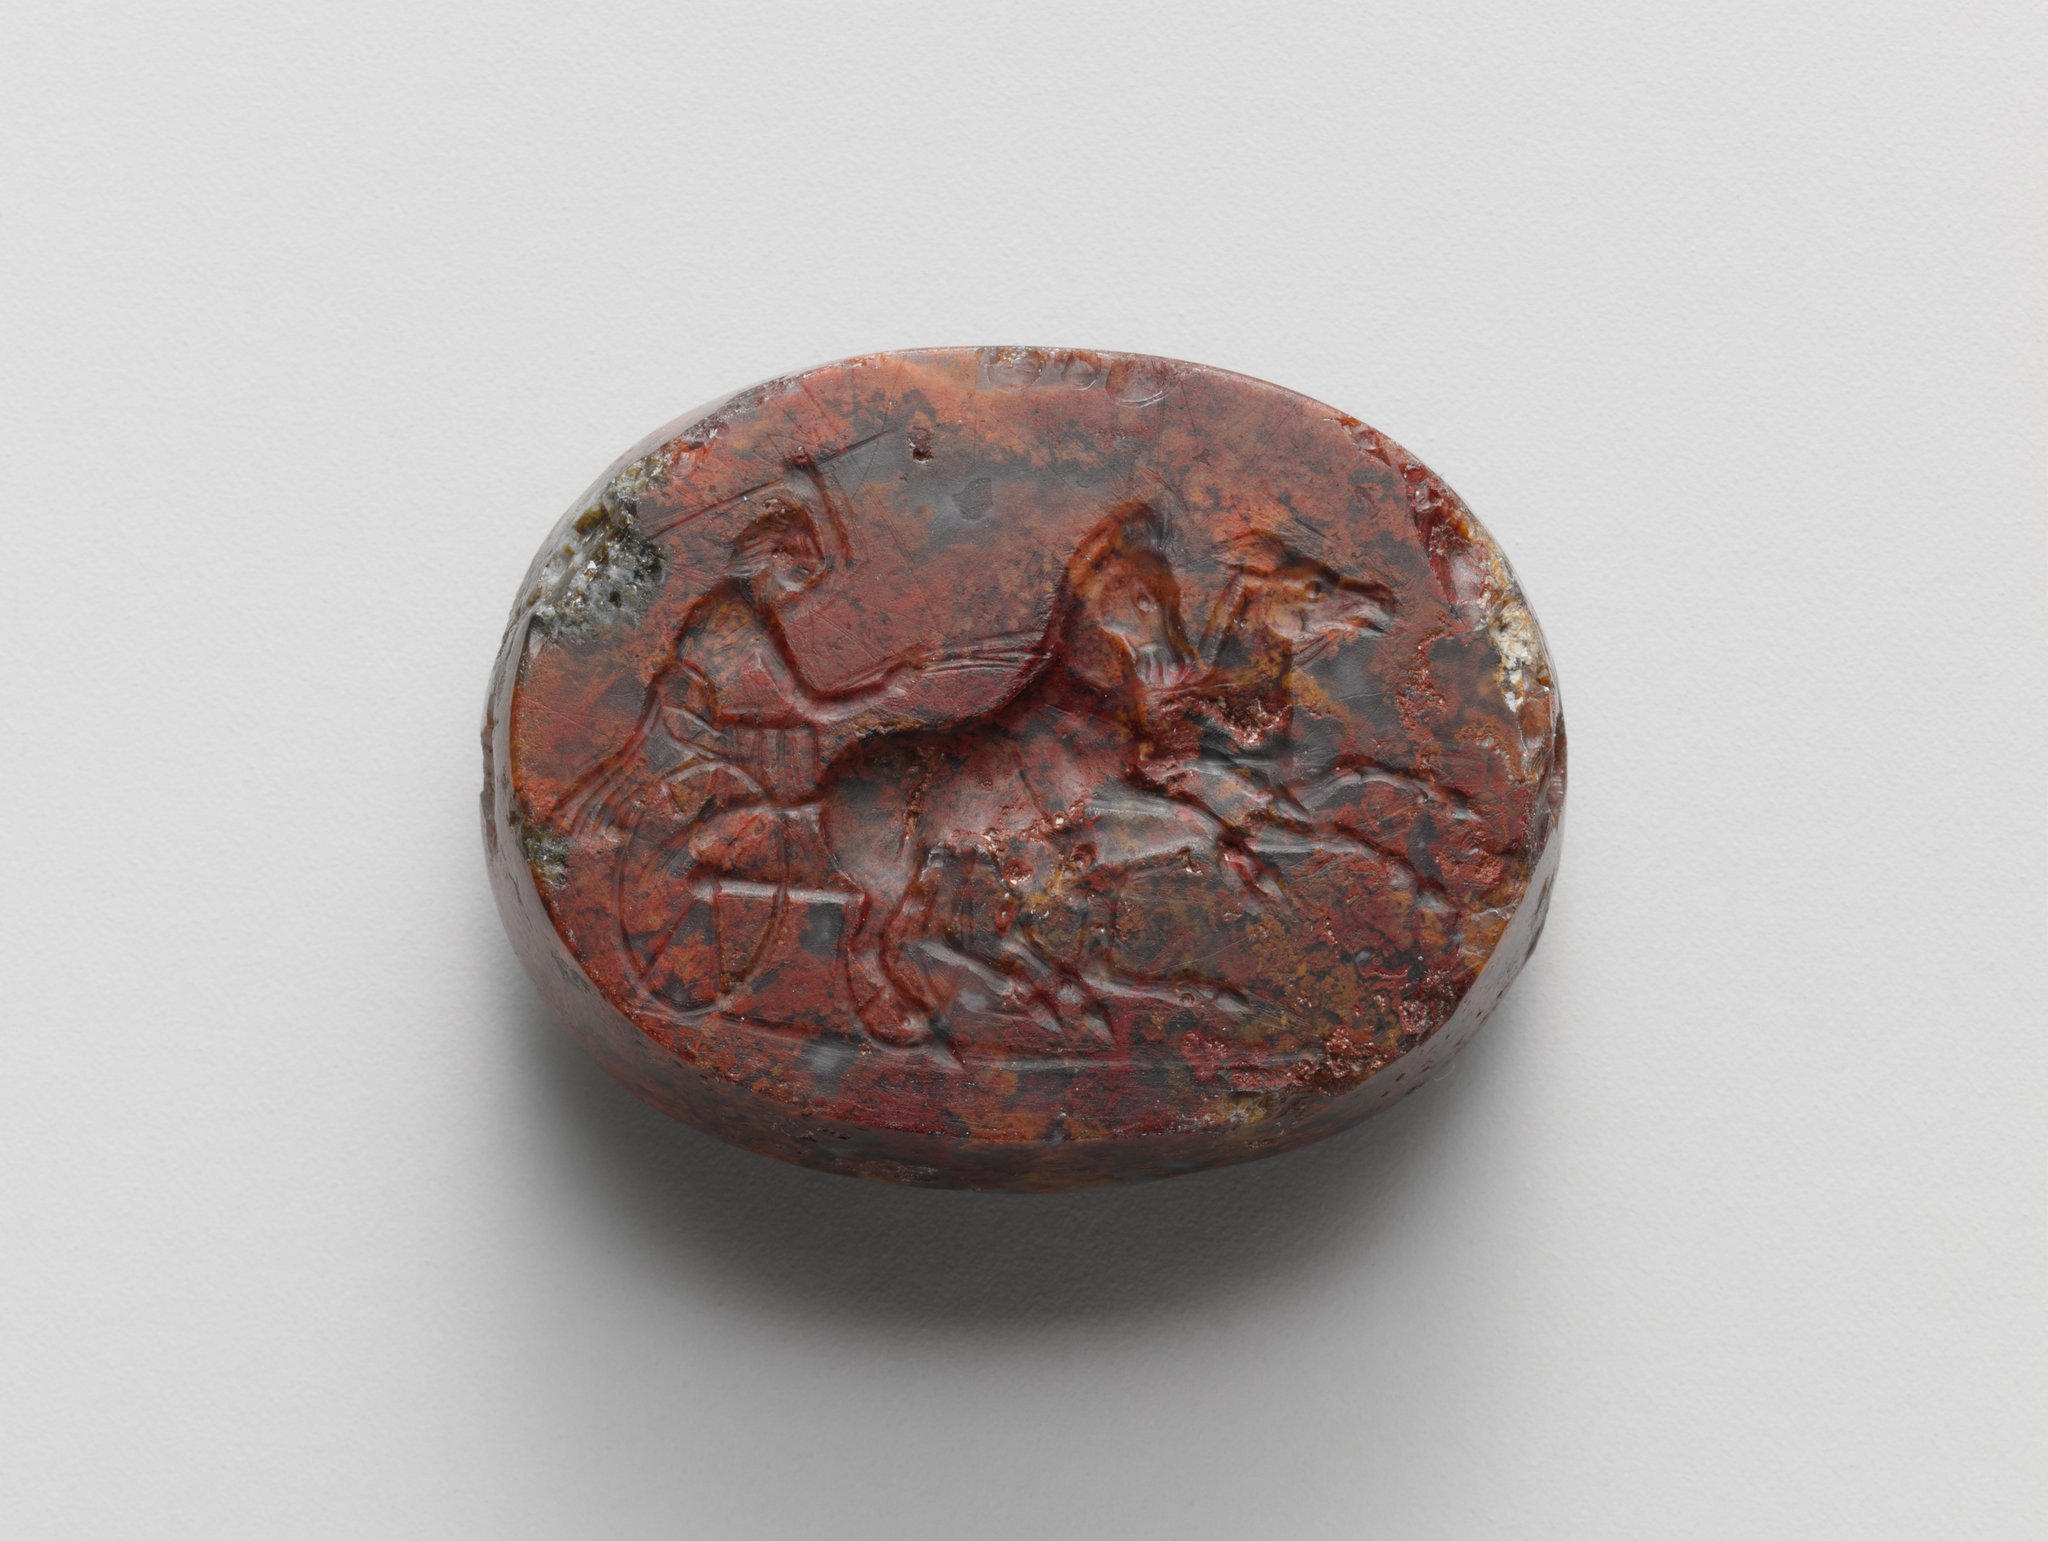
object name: scaraboid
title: Red jasper scaraboid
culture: greek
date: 434-368 BCE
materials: jasper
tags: human figures,horses,chariots